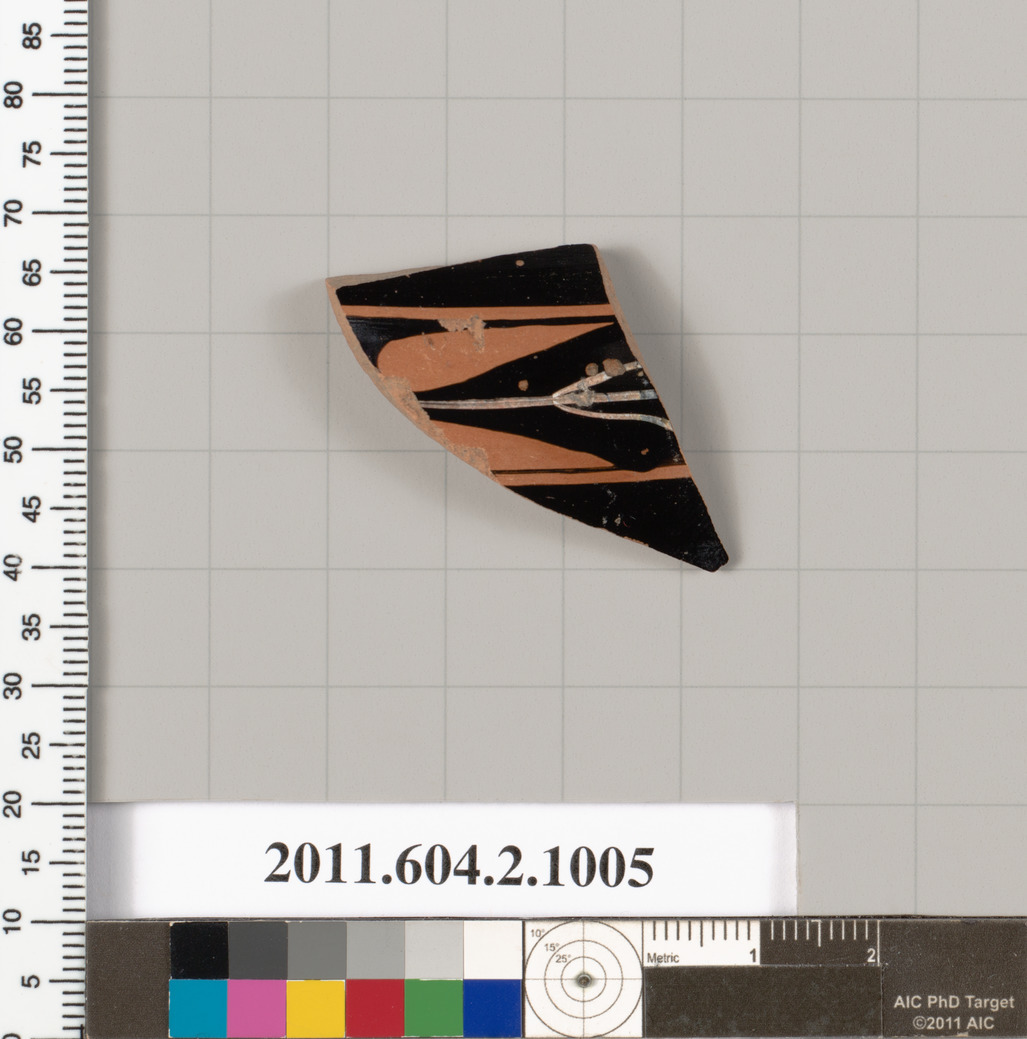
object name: oinochoe fragment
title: Terracotta fragment of an oinochoe (jug)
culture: greek, attic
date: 460-440 BCE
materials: terracotta